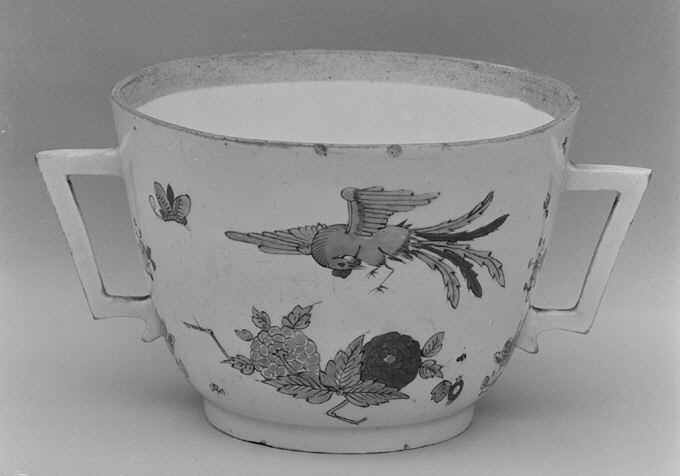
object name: écuelle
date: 1725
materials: hard paste porcelain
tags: birds,flowers